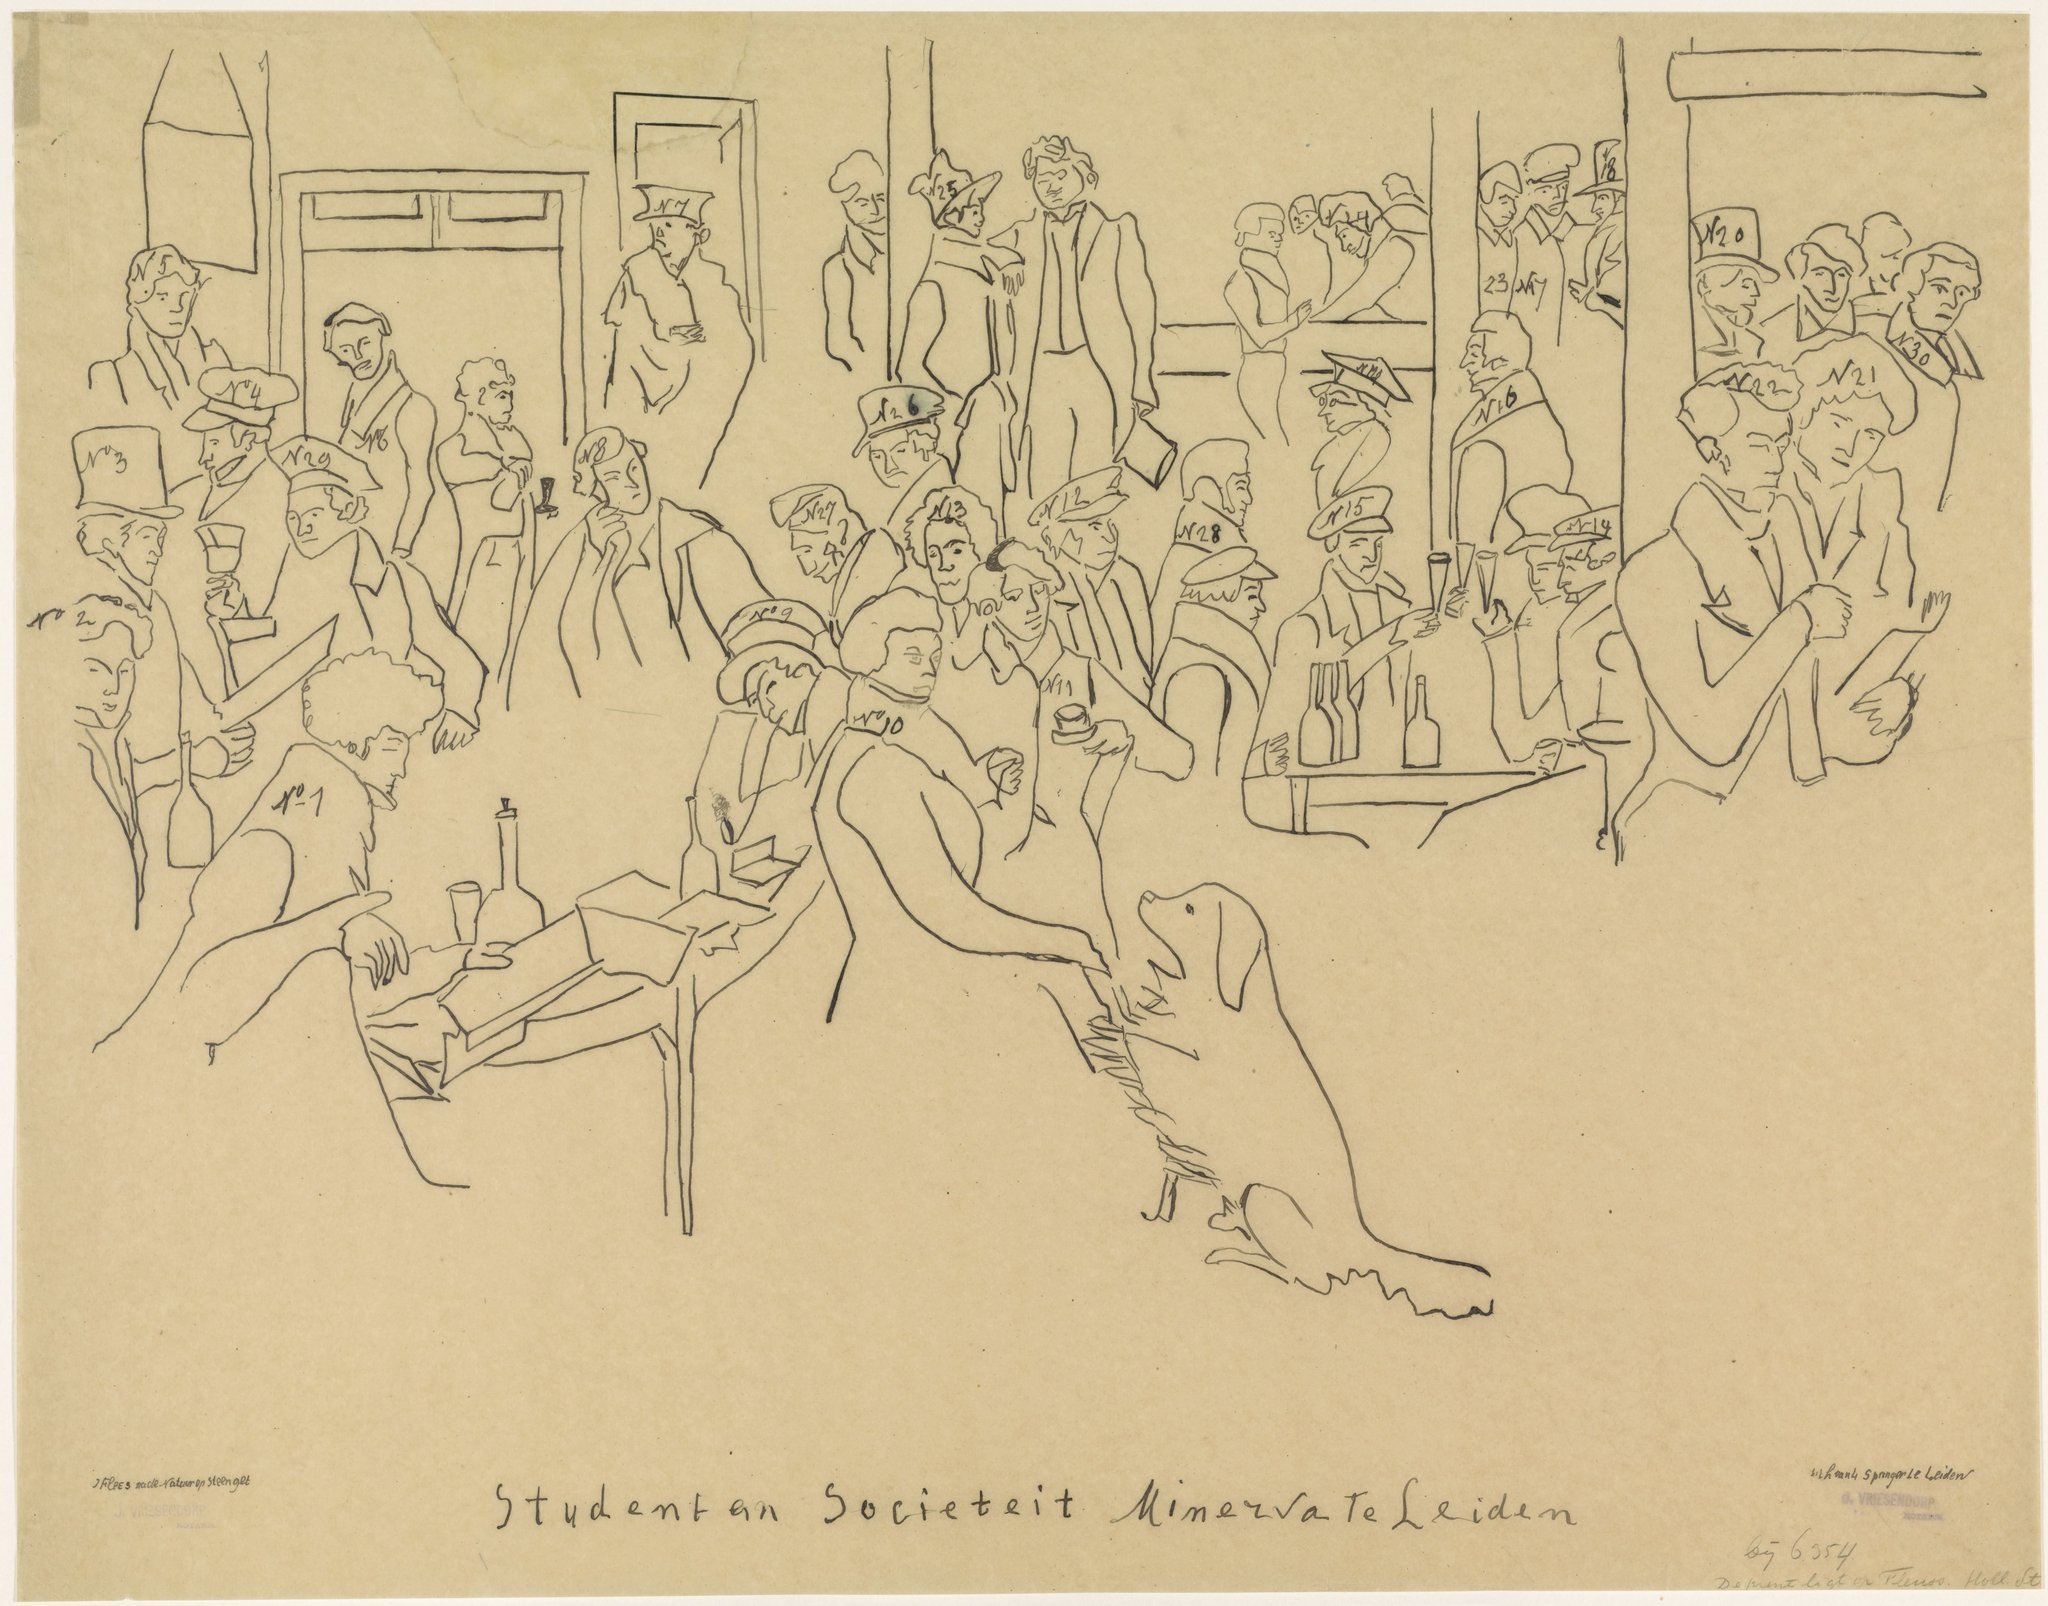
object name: drawing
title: Studentensociëteit Minerva te Leiden, 1829-1830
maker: Anonymous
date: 1829-1830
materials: paper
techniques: pen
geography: netherlands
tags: fraternity (students), leiden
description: Bijeenkomst van studenten in de Studentensociëteit Minerva, op het Rapenburg te Leiden, studiejaar 1829-1830. Tekening in contouren, overgetrokken van de prent. De meeste figuren hebben cijfers die verwijzen naar hun namen in de losse legenda.